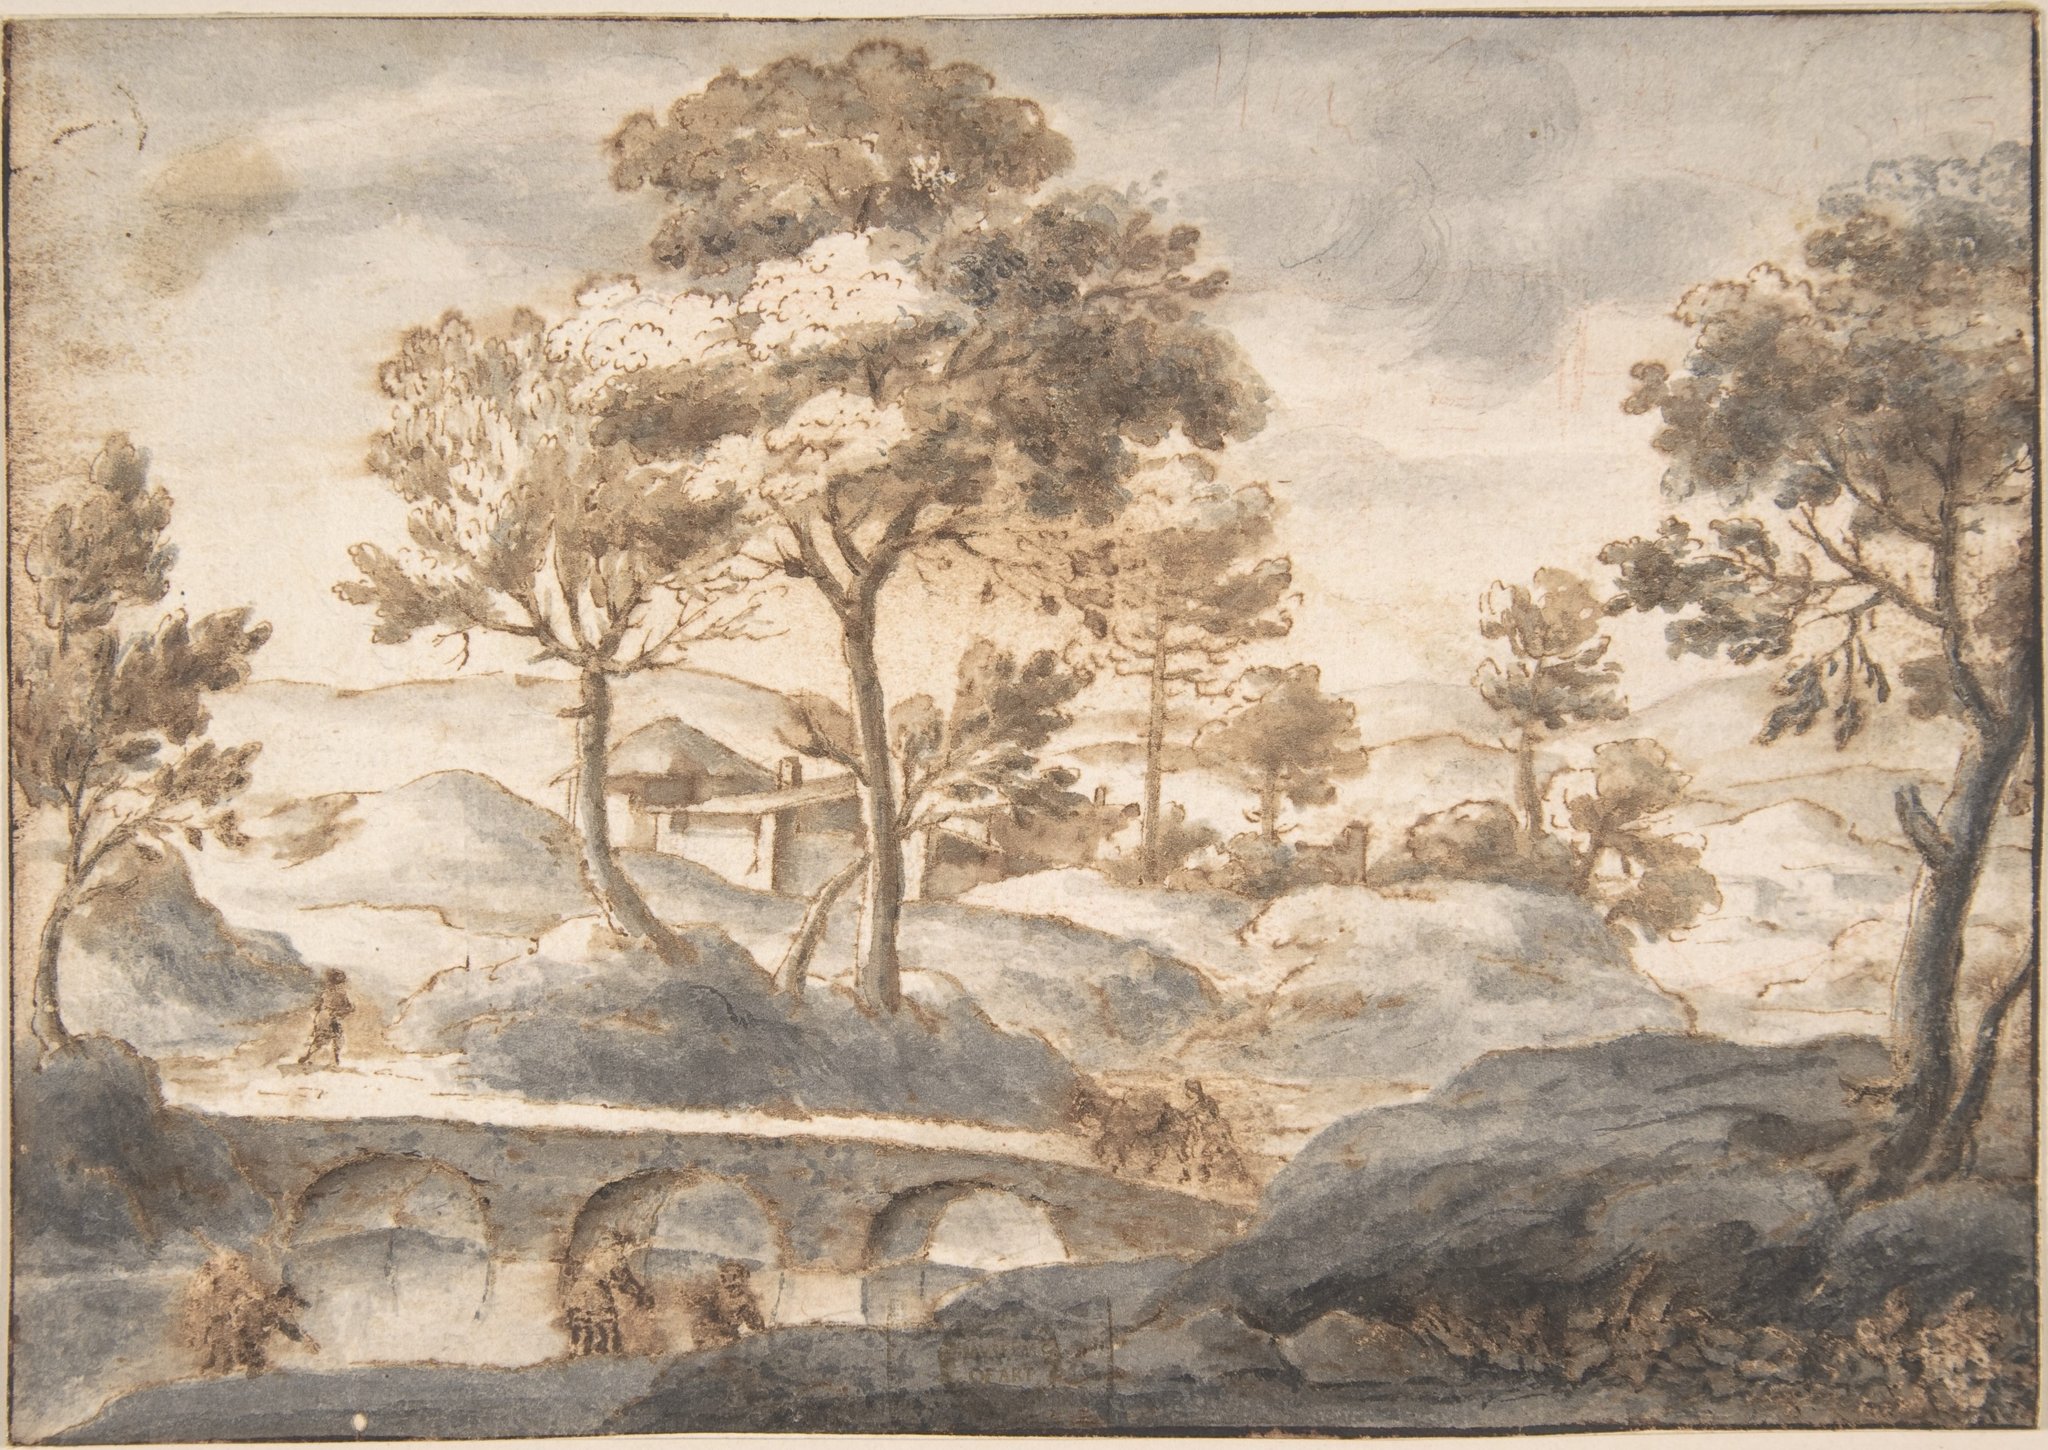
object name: drawing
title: Landscape with Bridge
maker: anonymous, italian, 17th century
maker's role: artist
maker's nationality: italian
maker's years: 1600-1700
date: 1601-1700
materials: ink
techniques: brush, pen, wash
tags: bridges,landscapes,trees